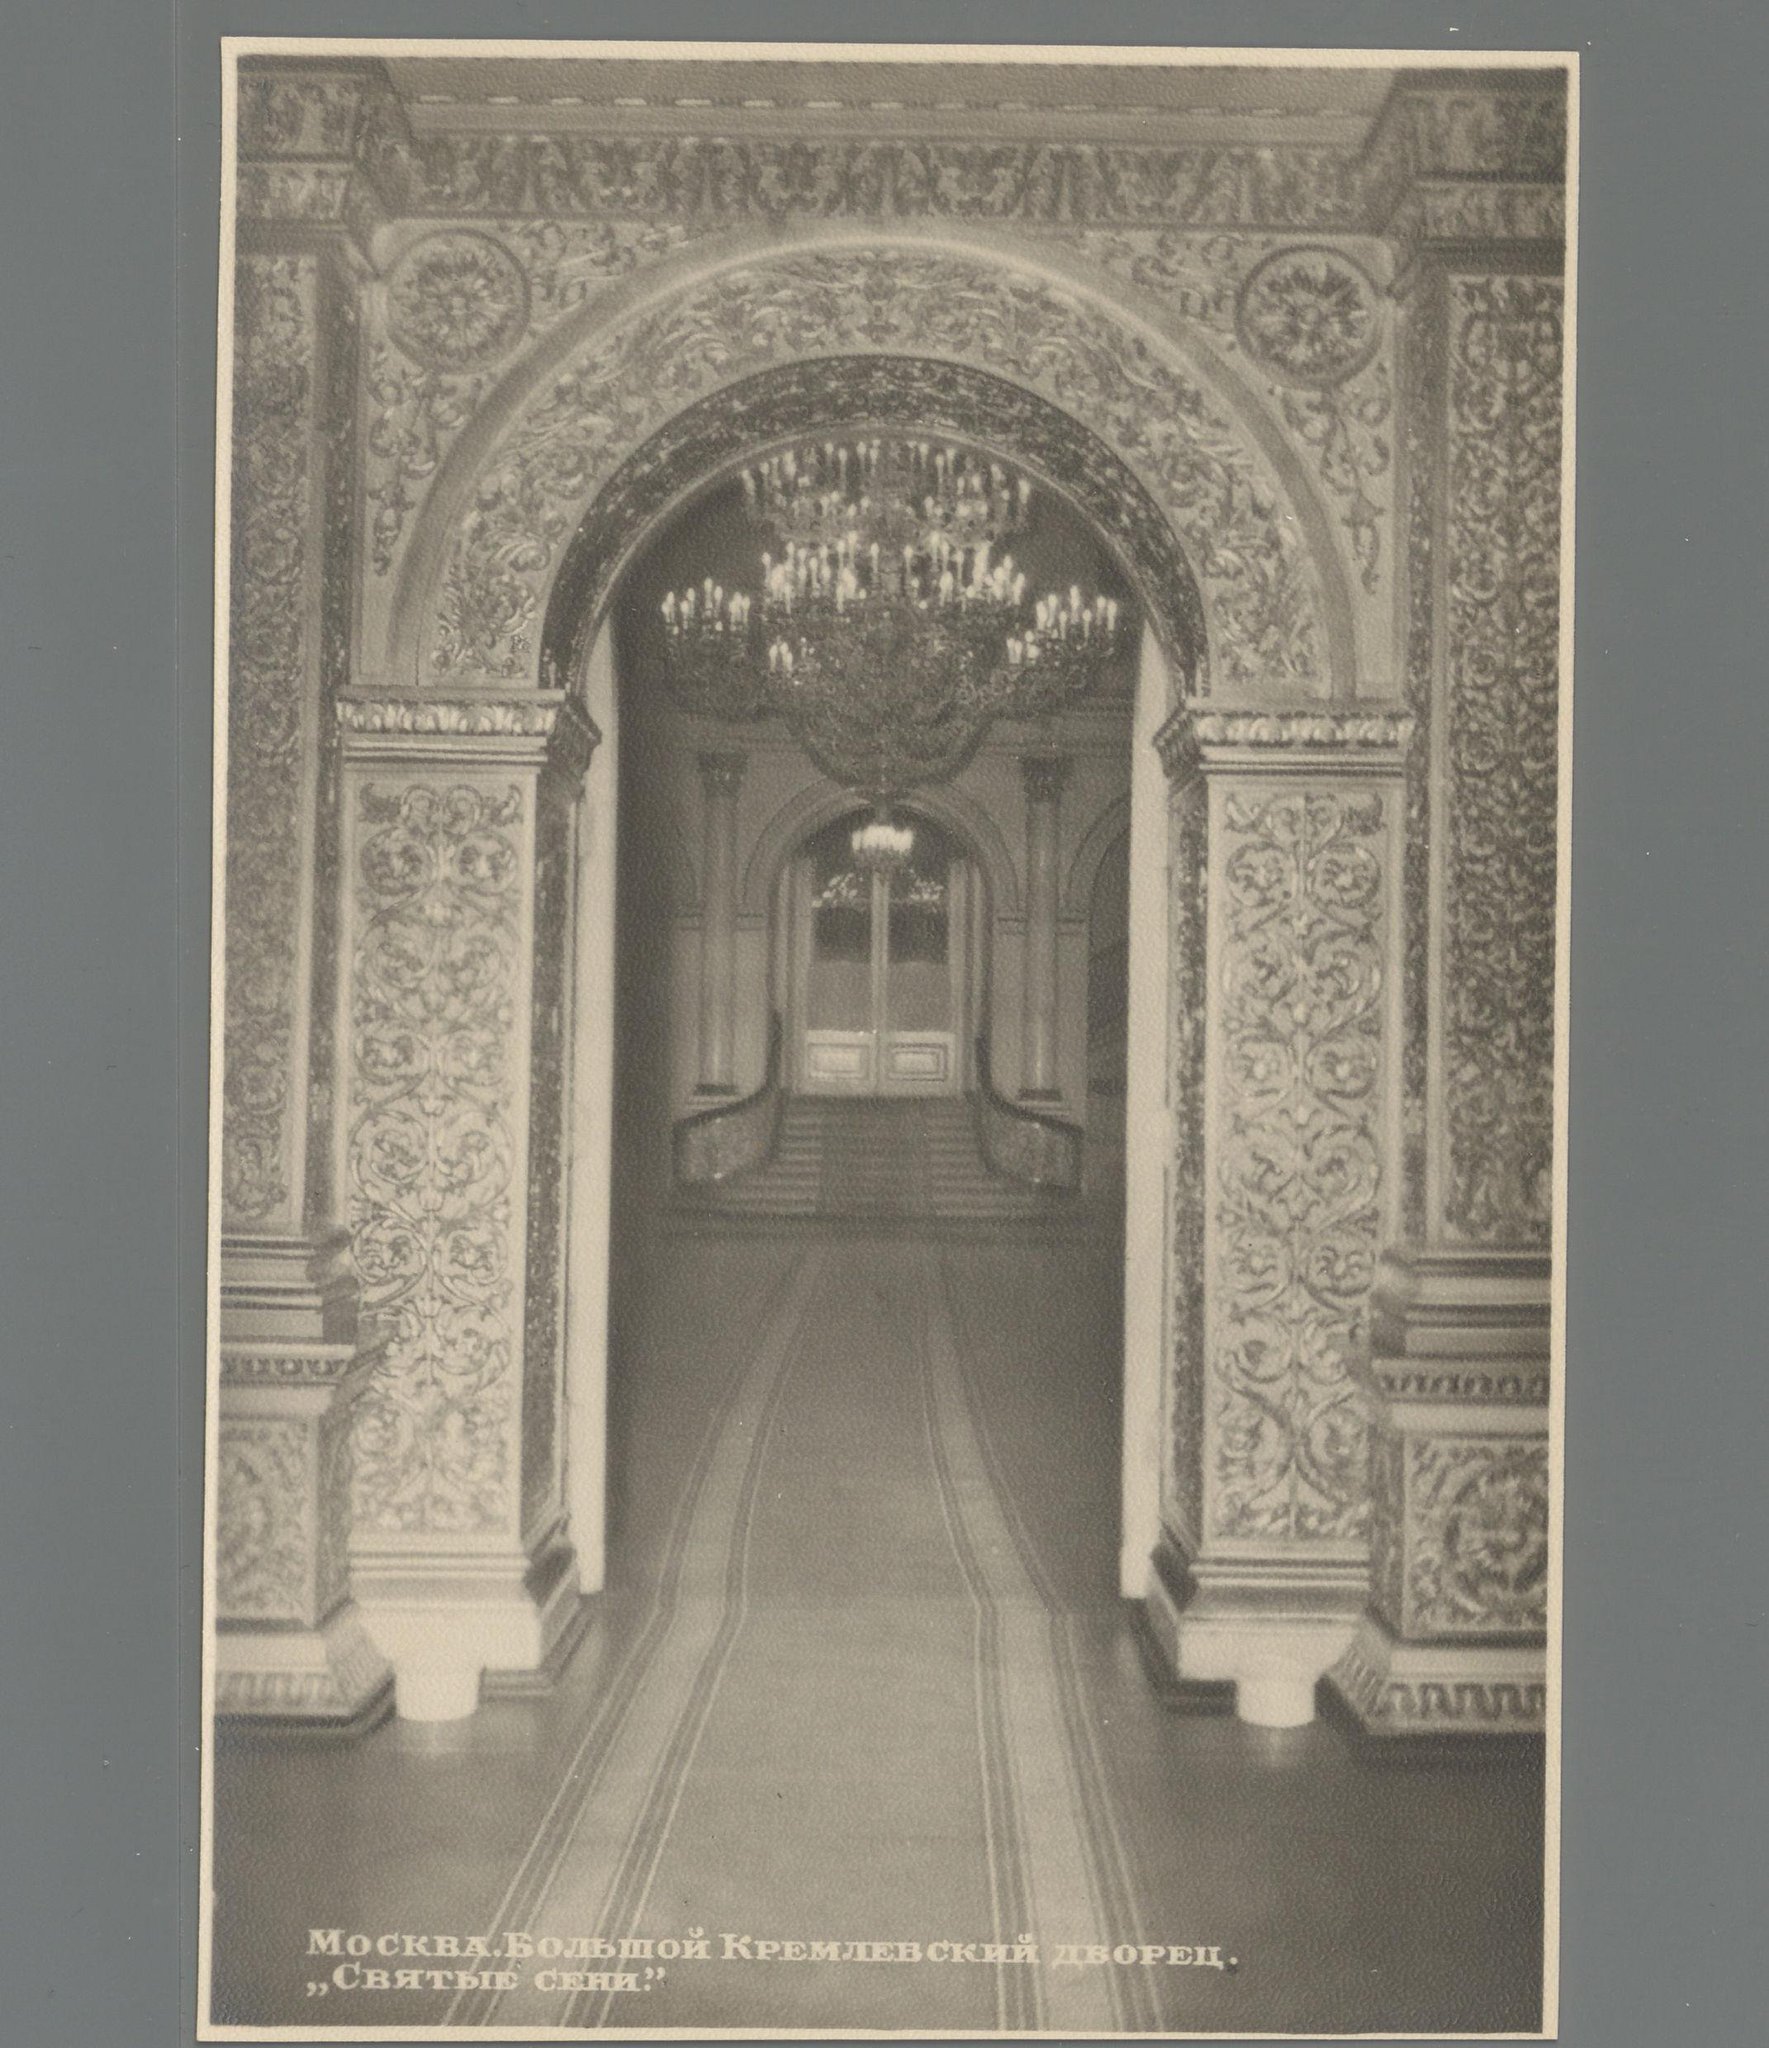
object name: ansichtkaart, prentbriefkaart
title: Interieur van het Groot Paleis in het Kremlin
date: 1954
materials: paper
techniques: gelatin silver print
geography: moscow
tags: palace, interior of the house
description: De titel op object staat in het Russisch.